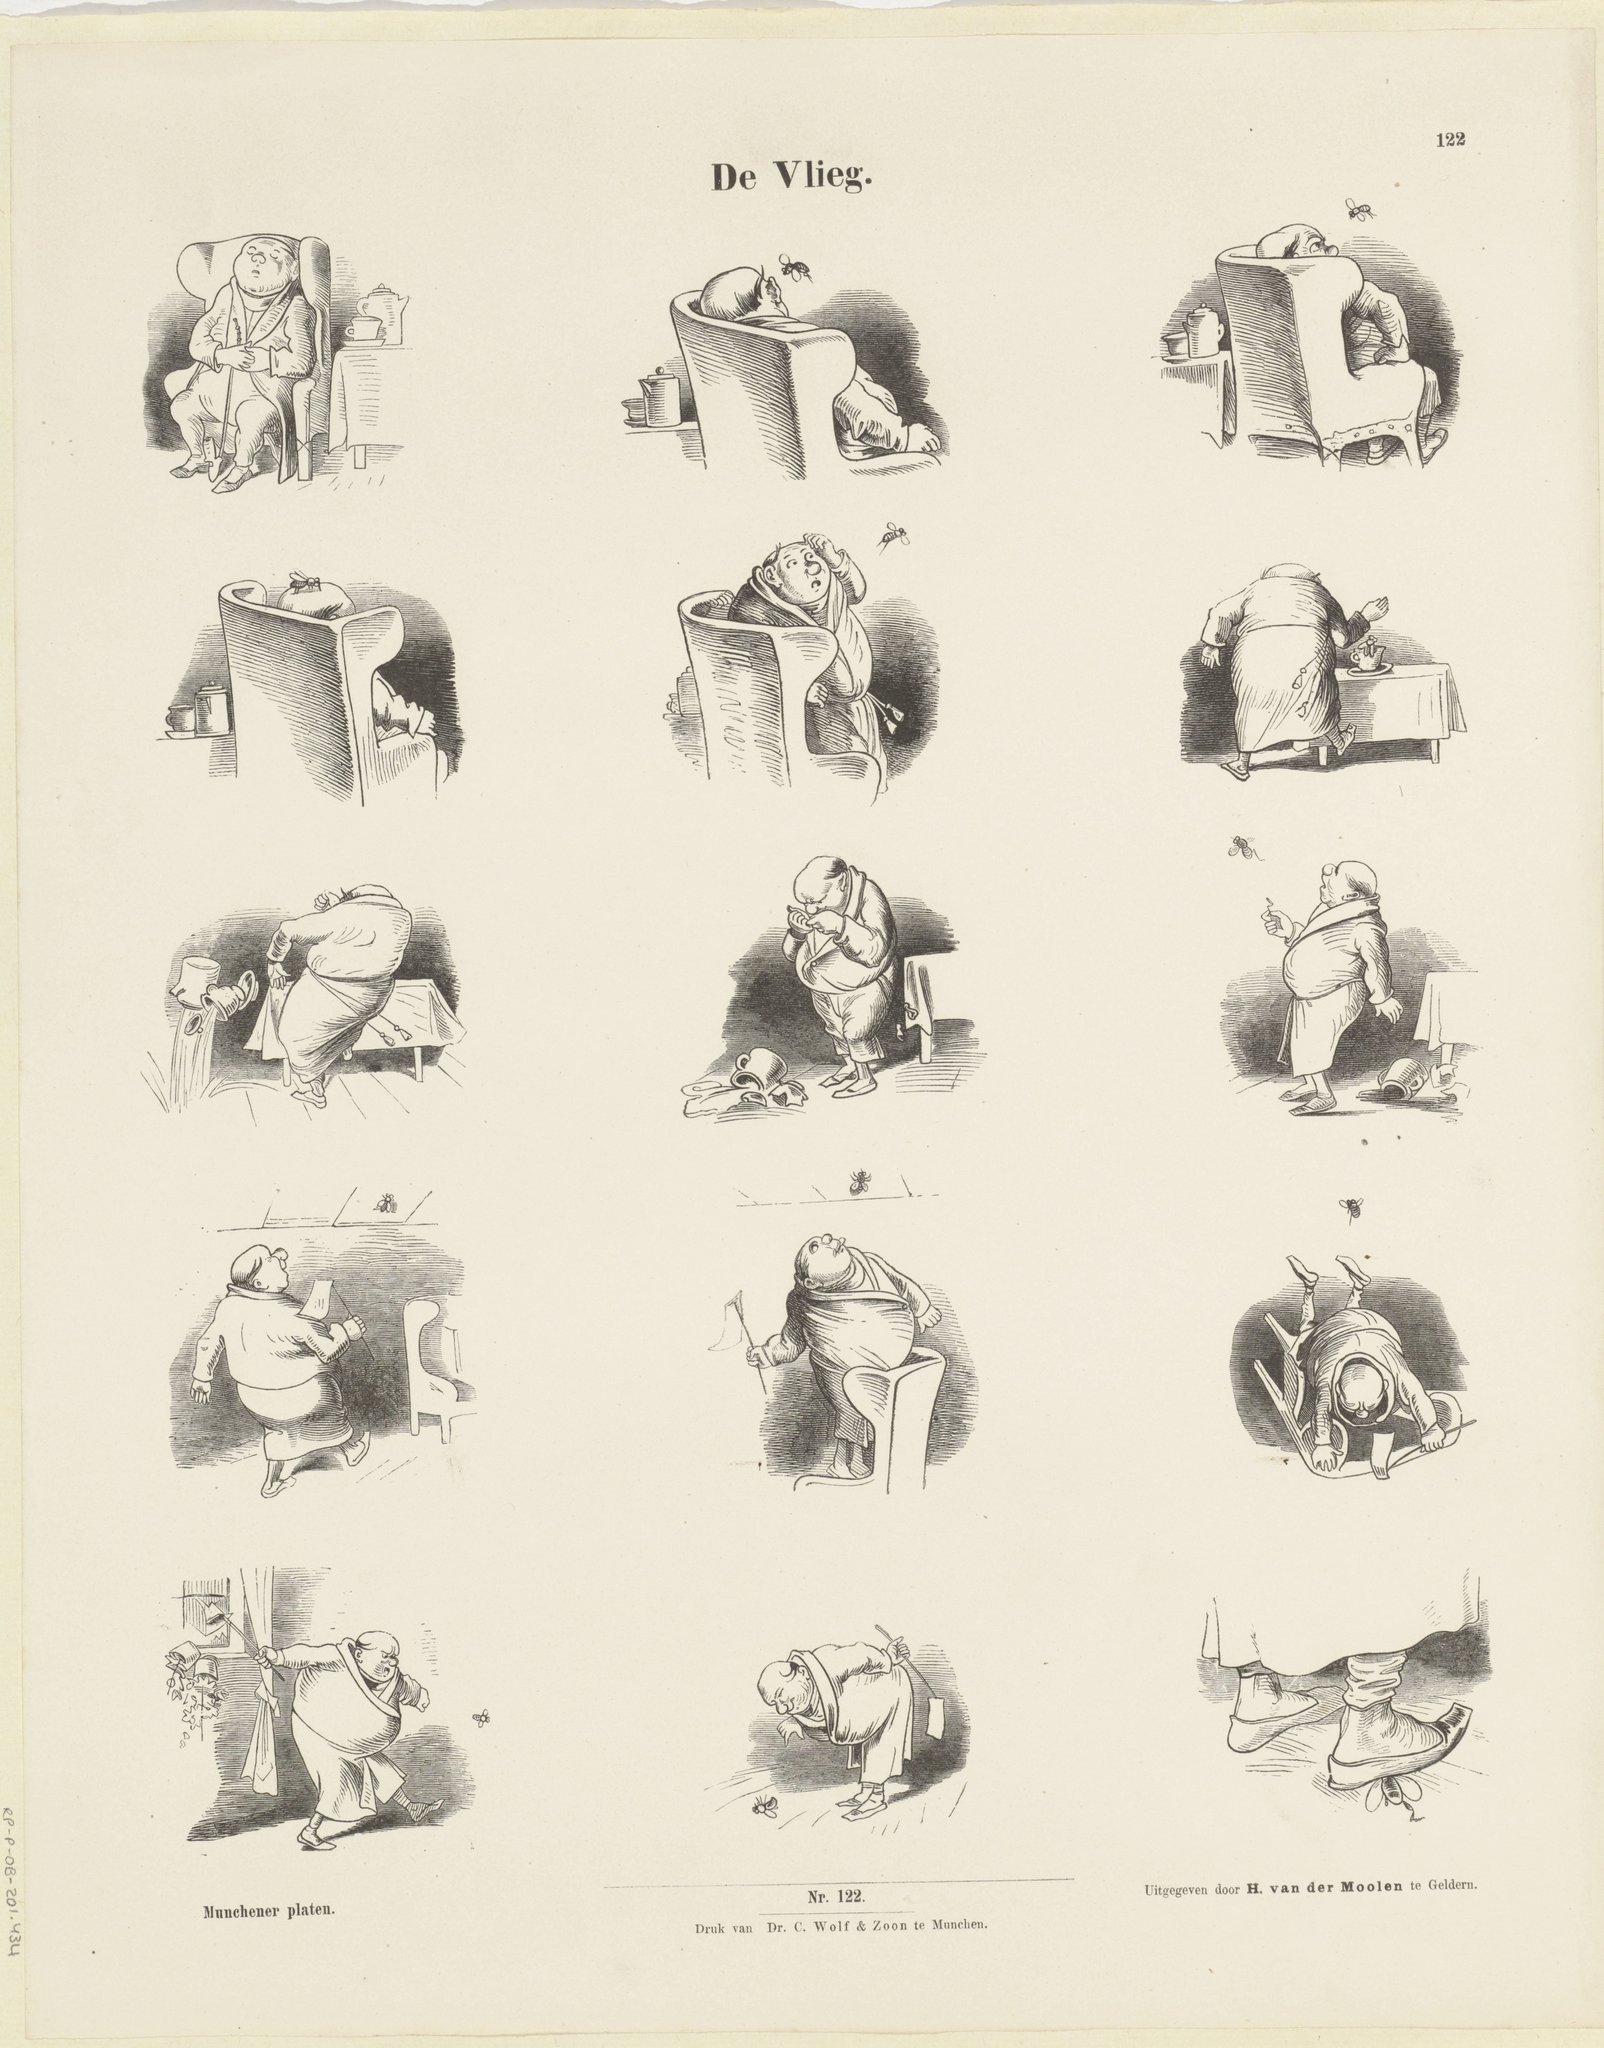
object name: print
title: De vlieg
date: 1843-1920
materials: paper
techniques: letterpress printing, engraving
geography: munich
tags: fly swatter, insects: fly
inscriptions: collector's mark: Lugt 2760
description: Blad met 15 voorstellingen over een man dier er na veel moeite in slaagt een irritante vlieg (wesp?) te vangen. Genummerd midden onder: Nro. 122. Genummerd rechtsboven: 122.